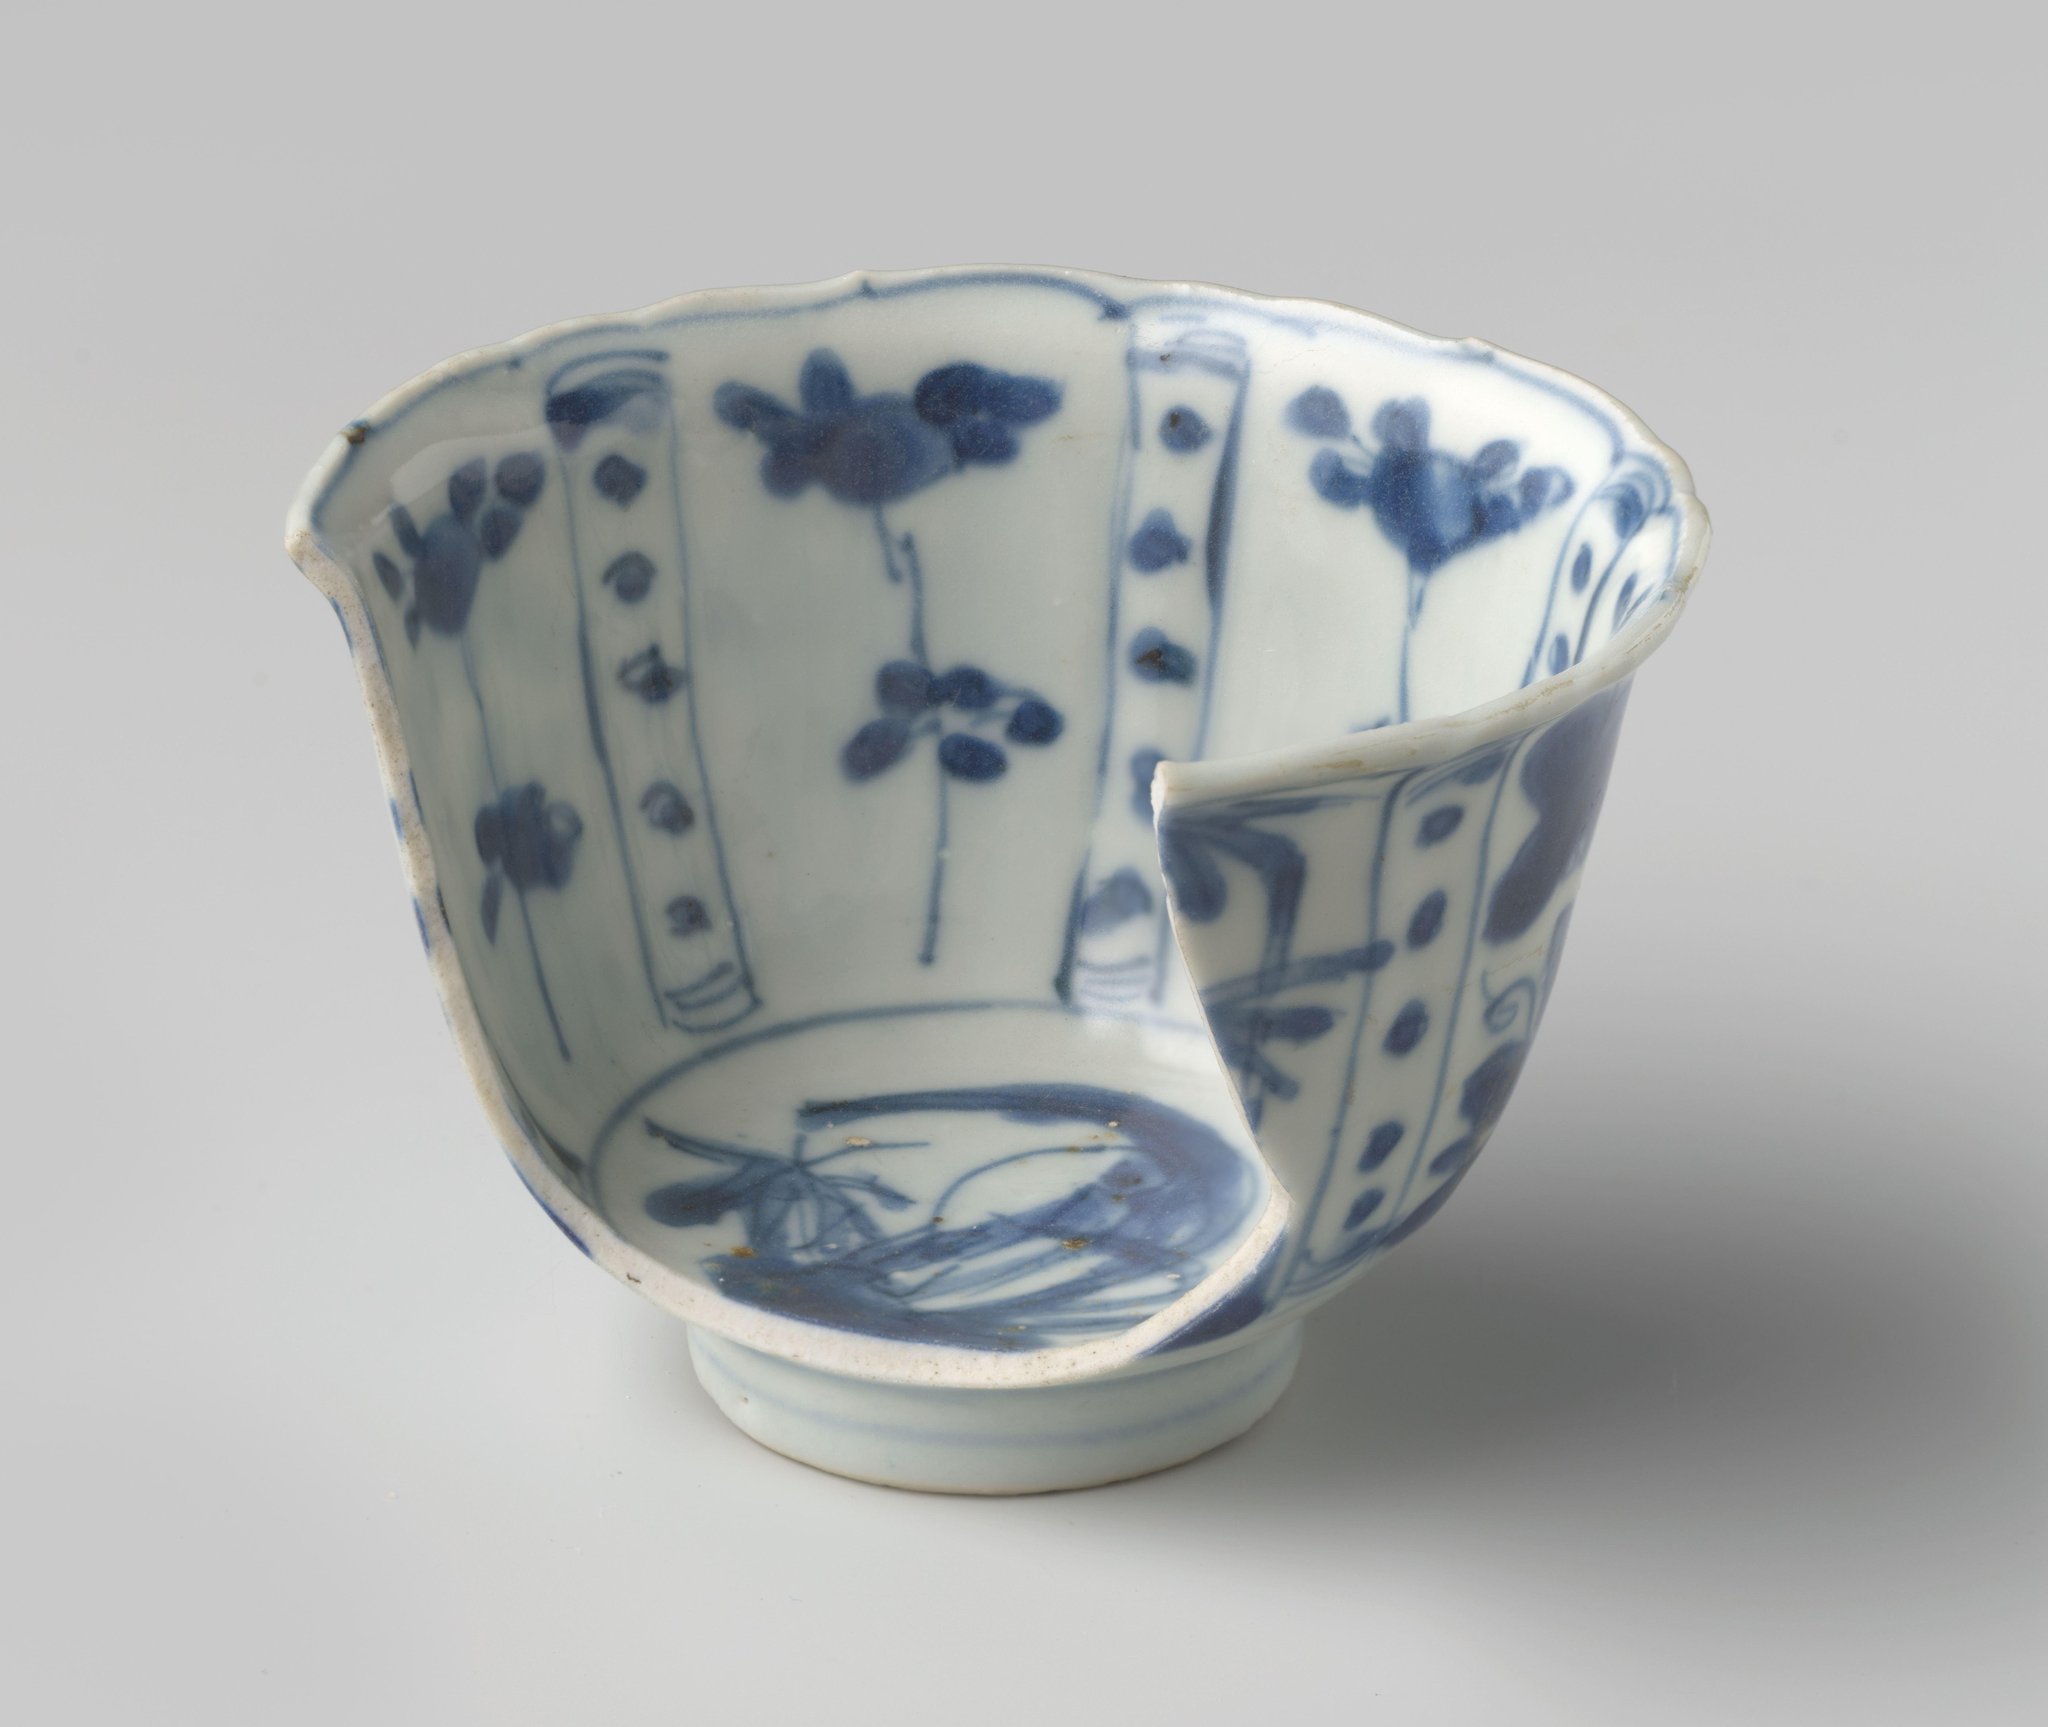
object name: bowl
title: Kom uit V.O.C.-schip de 'Witte Leeuw'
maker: Anonymous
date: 1613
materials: bone china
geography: jingdezhen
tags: verenigde oostindische compagnie, sint-helena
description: A high bowl. The interior panels are decorated with peach-sprays. The exterior with bamboo and butterflies. The narrow panels have lingzi (fungi). This piece is of a better quality than the other ones of this type.